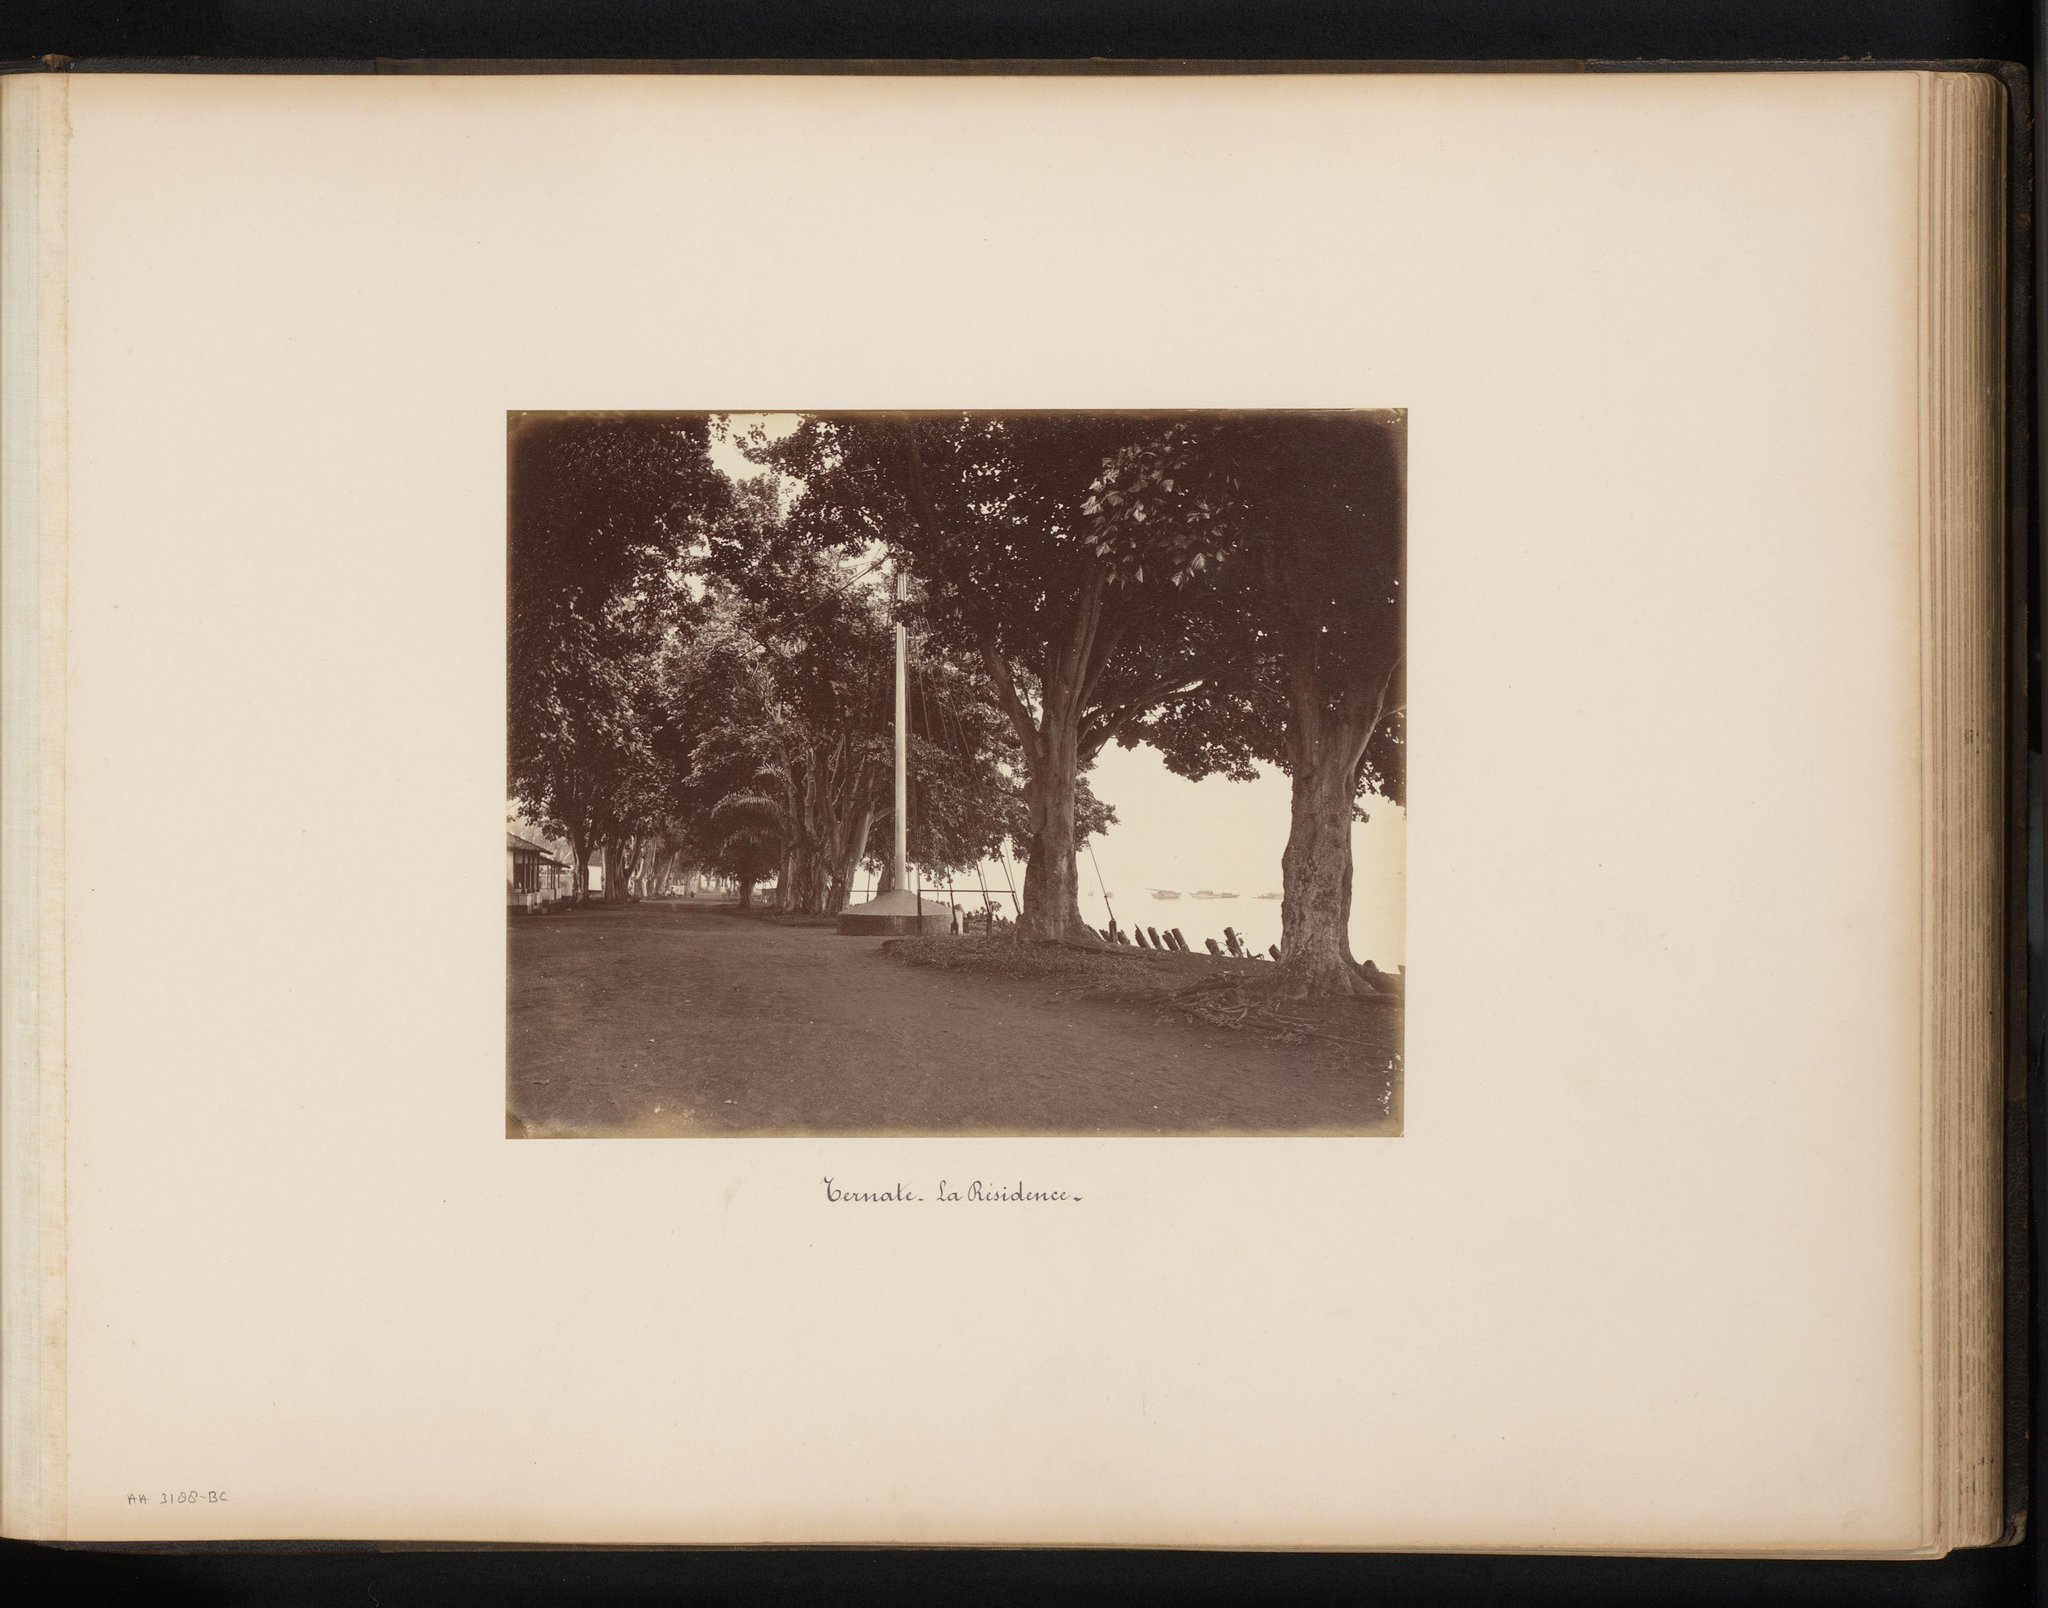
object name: photograph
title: Laan aan de kust bij de residentie van Ternate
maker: Anonymous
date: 1880-1883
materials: photographic support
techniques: albumen print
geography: ternate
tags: forest path or lane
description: Onderdeel van Reisalbum met opnames van bezienswaardigheden in Egypte, Nederlands-Indië, Singapore en Ceylon.